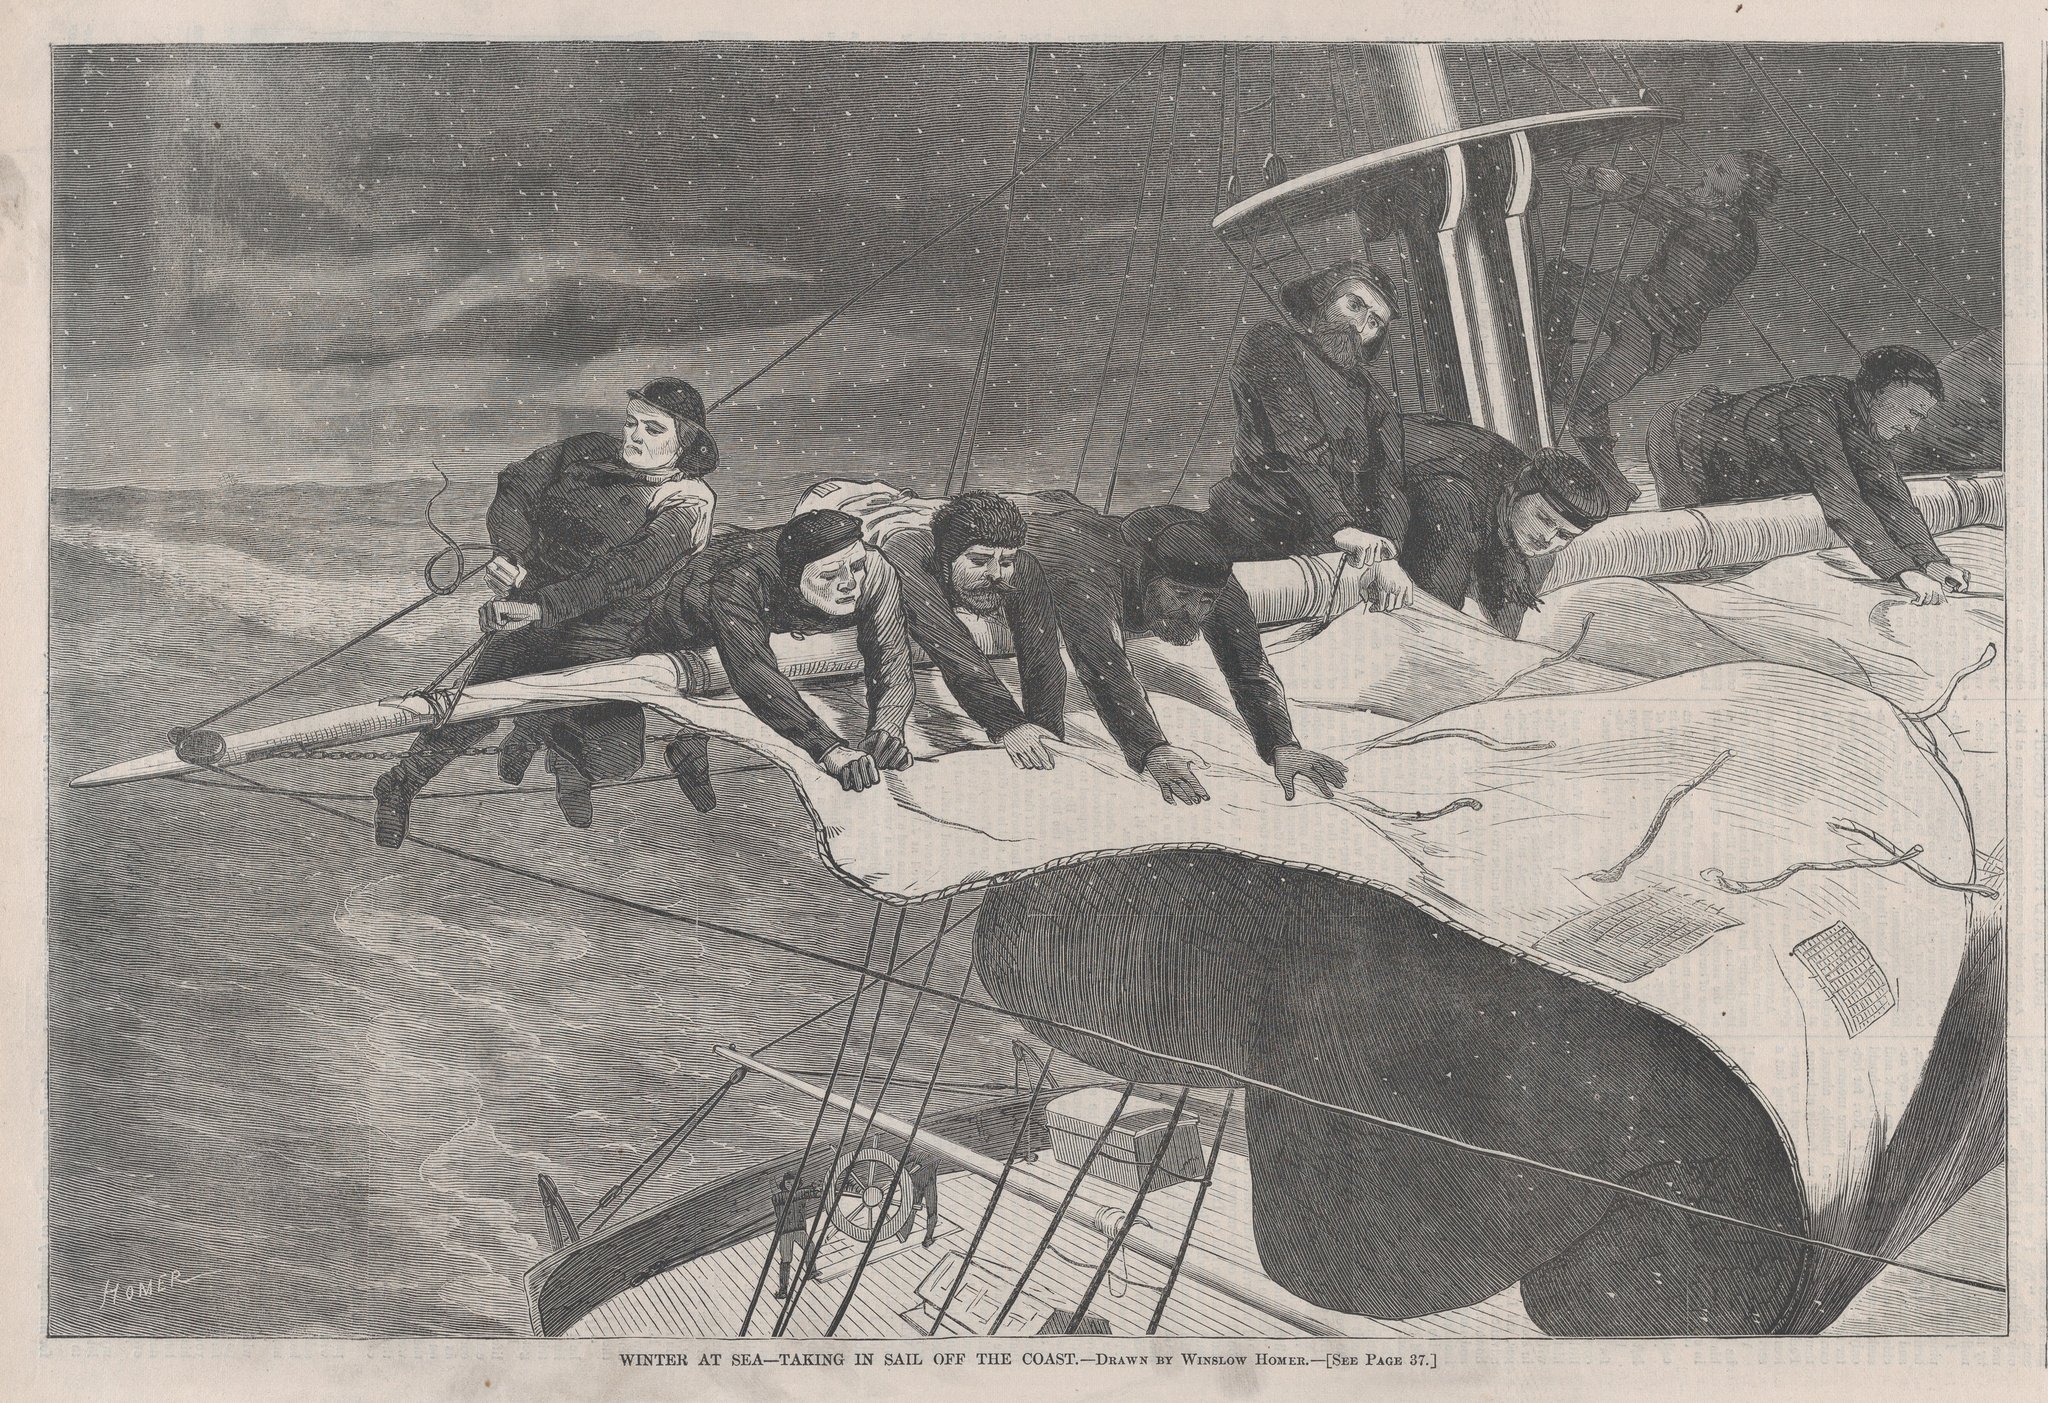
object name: print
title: Winter at Sea – Taking in Sail off the Coast (from "Harper's Weekly," Vol. XIII)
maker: winslow homer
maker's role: artist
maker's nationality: american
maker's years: 1836-1910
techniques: engraving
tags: men,seas,winter,ships